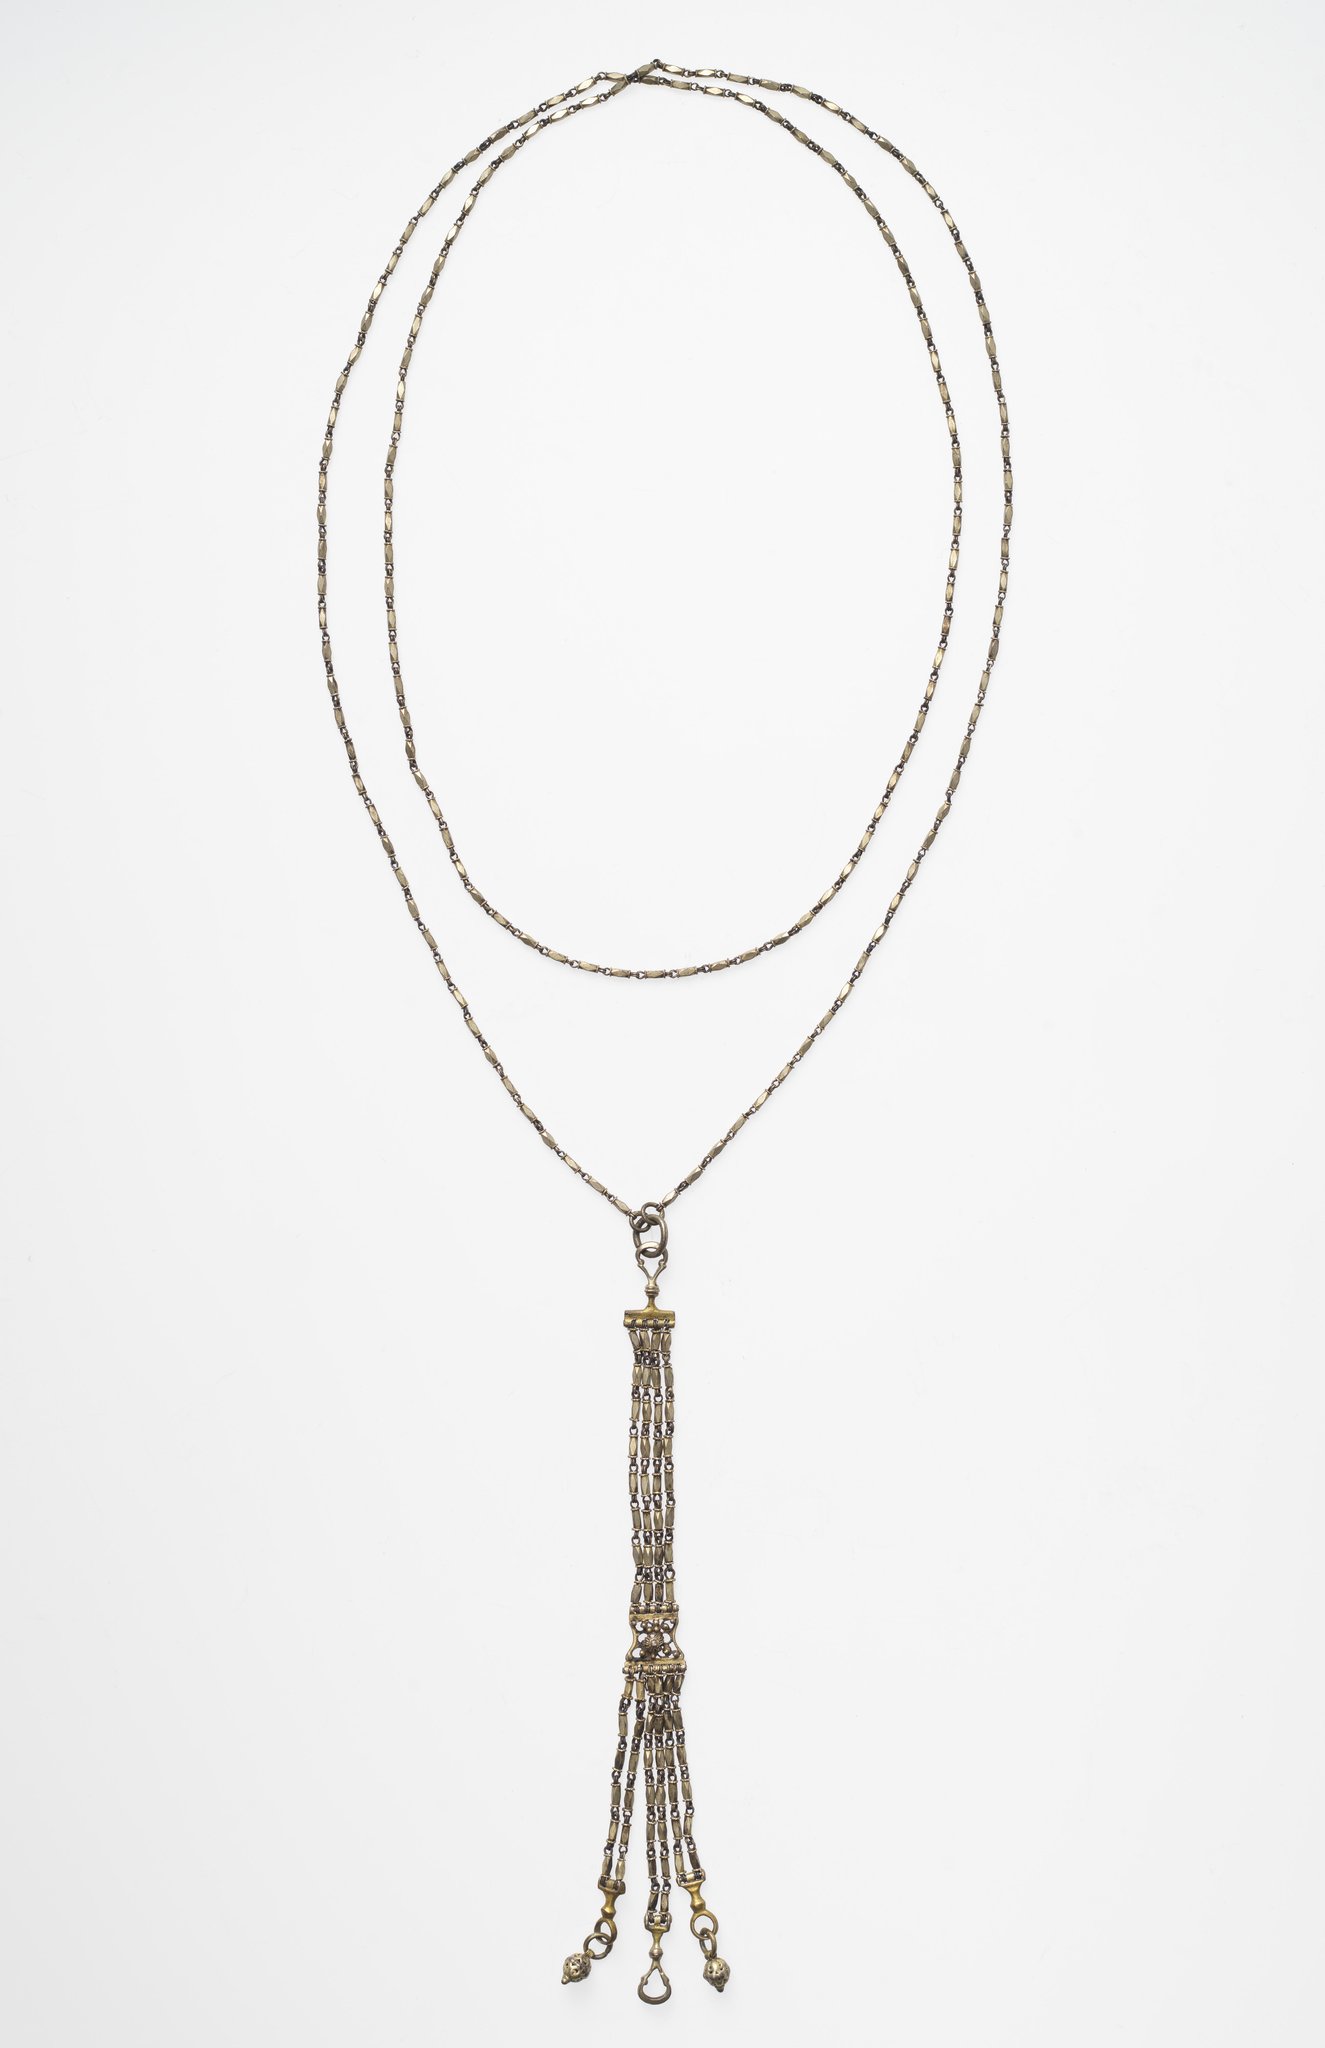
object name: necklace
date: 1701-1900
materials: gold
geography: india